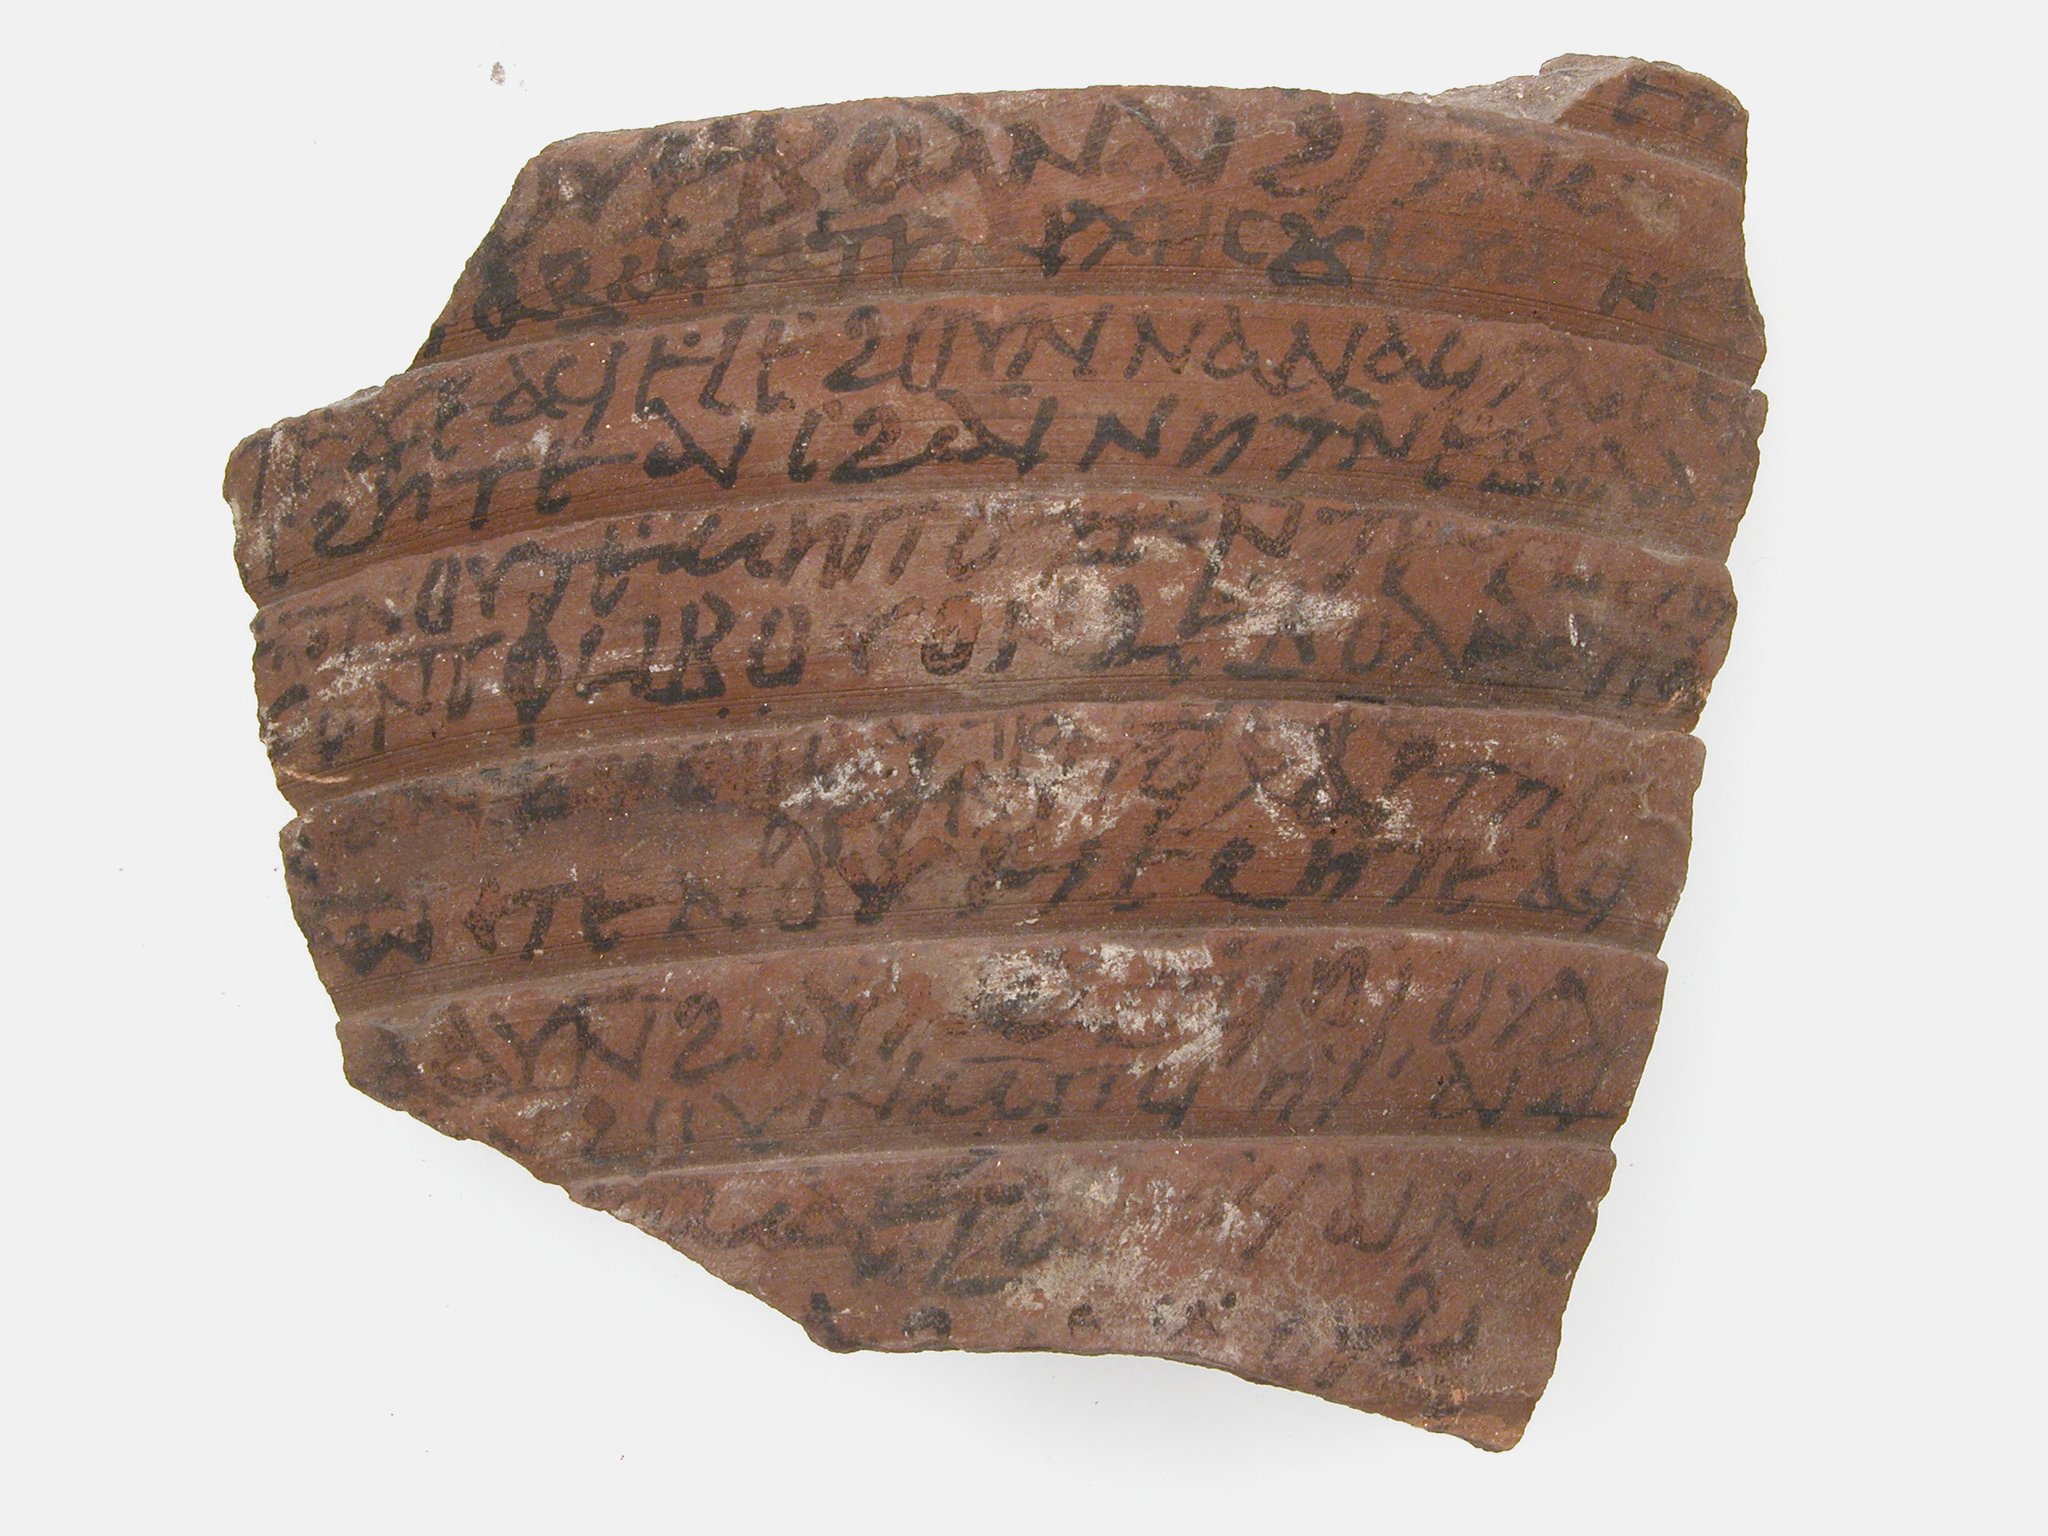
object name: ostrakon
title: Ostrakon with a Letter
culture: coptic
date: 600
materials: ink, pottery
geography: egypt